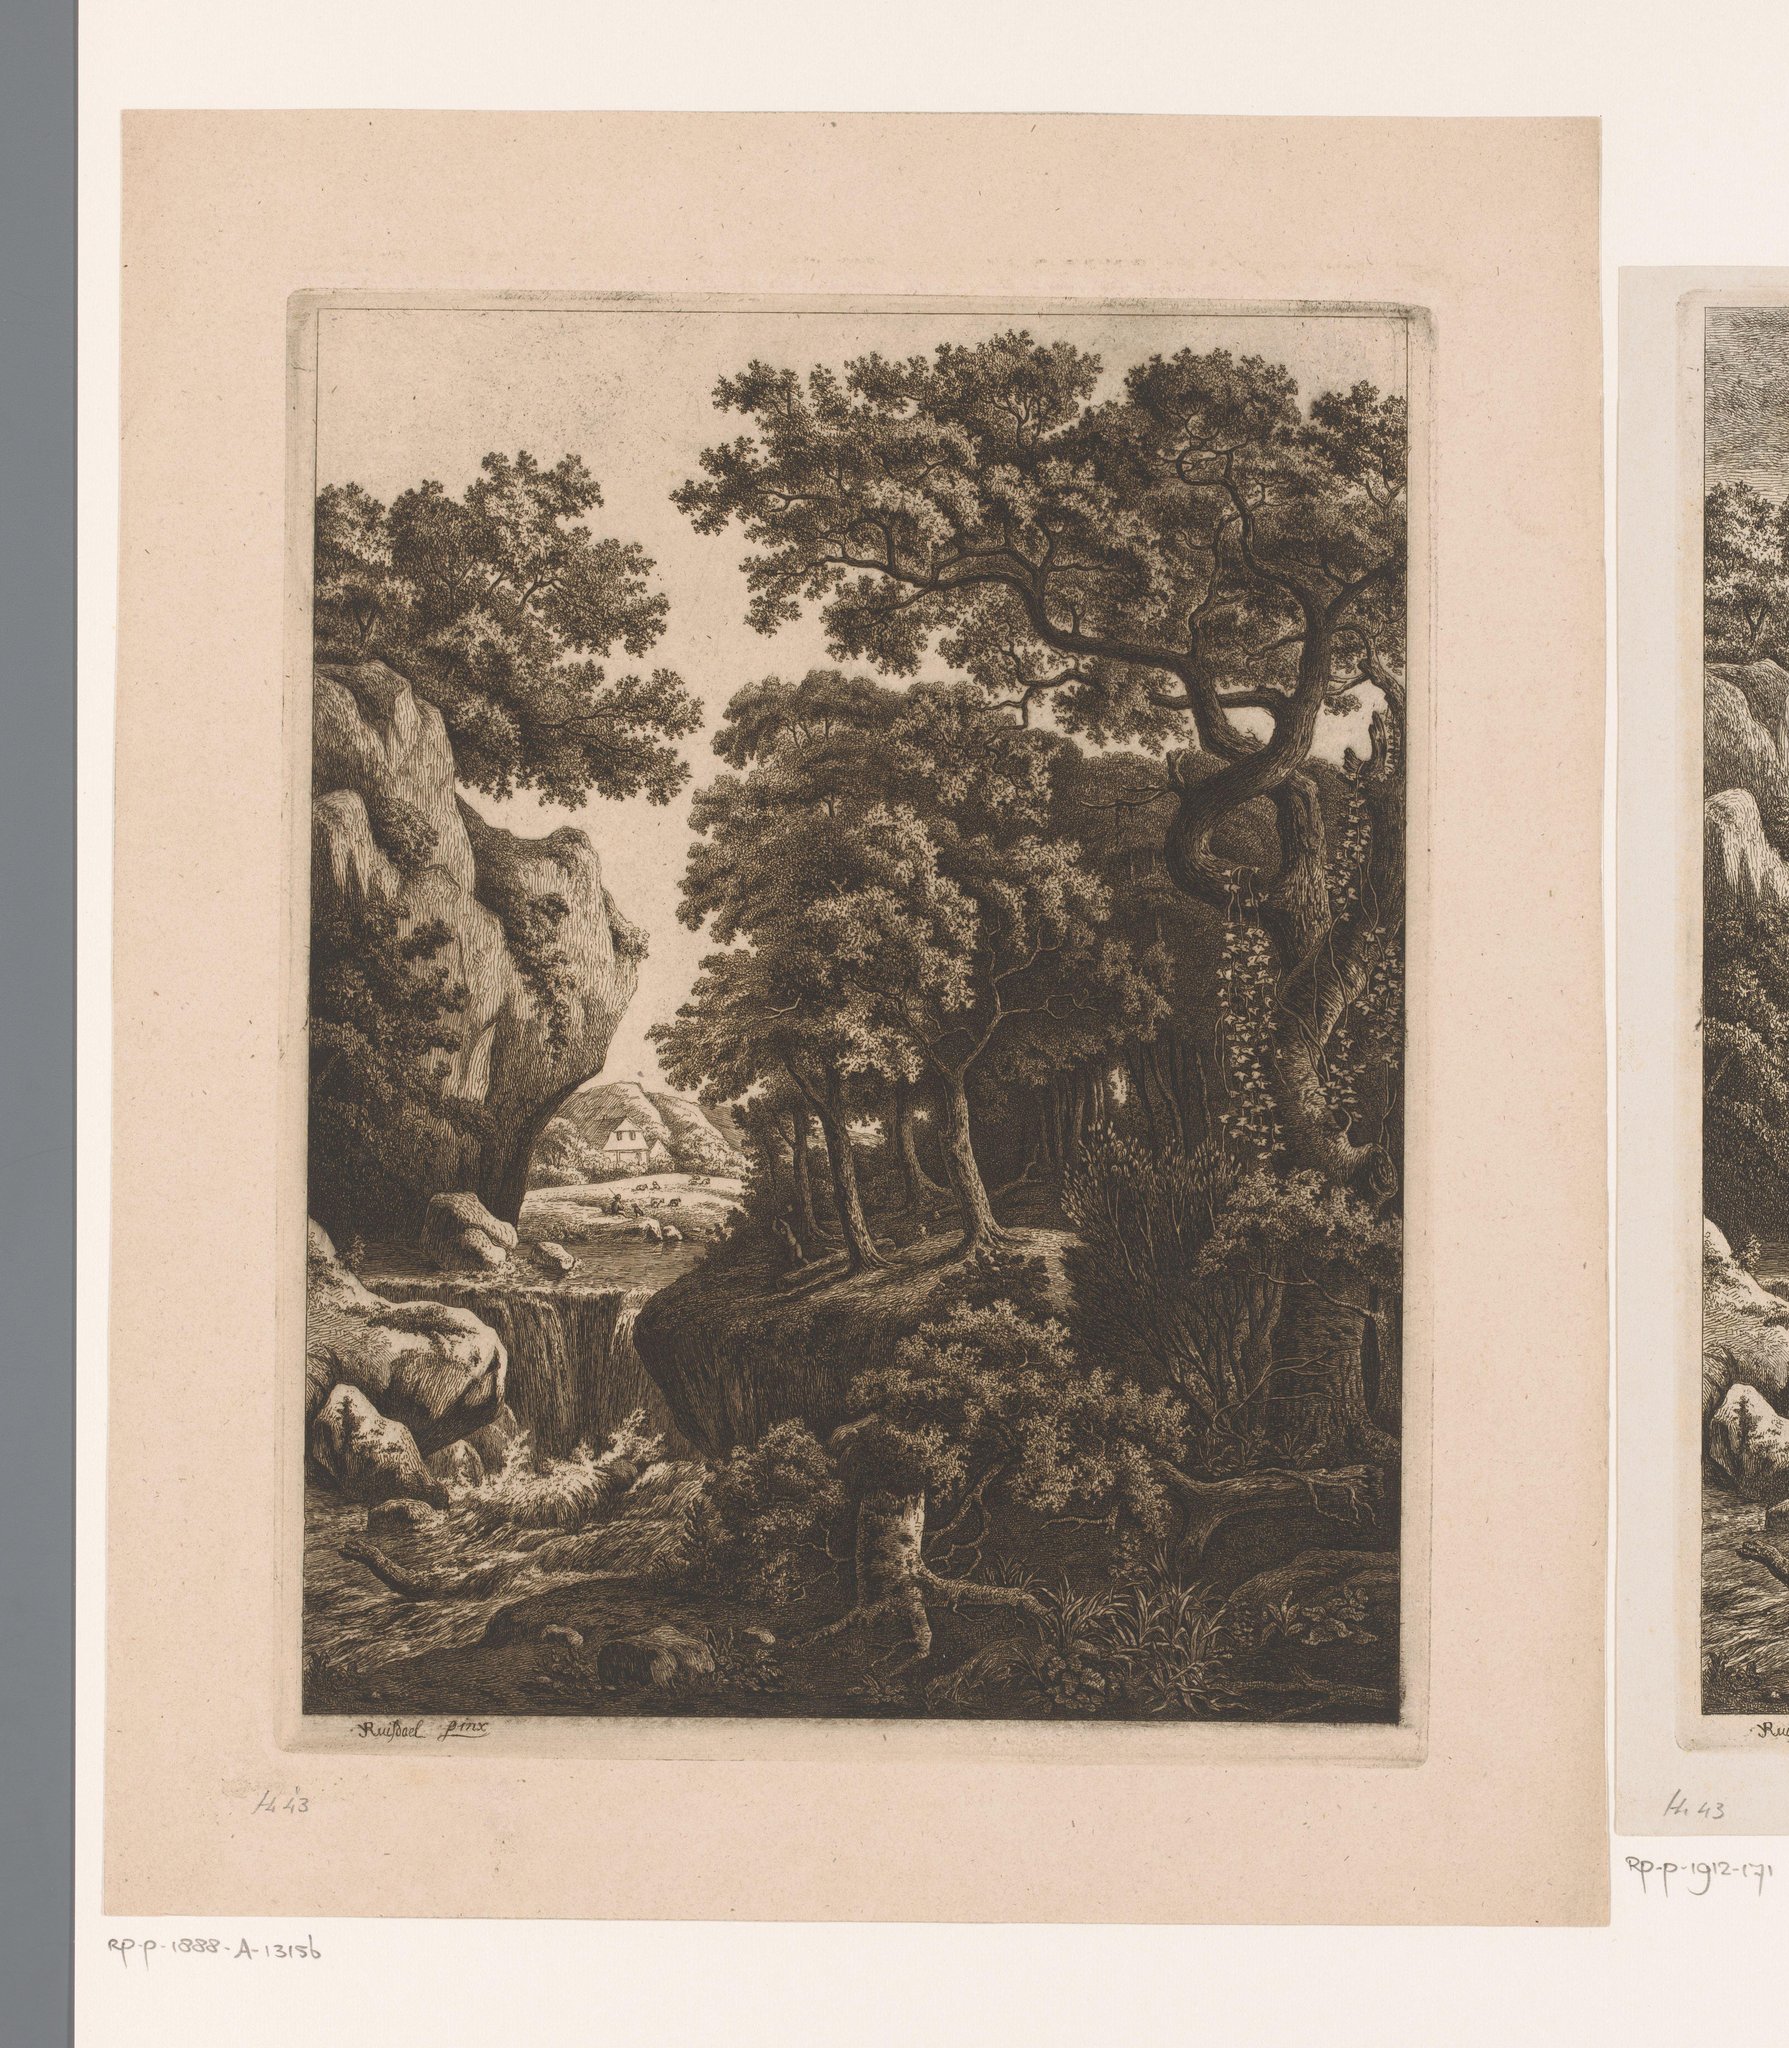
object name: print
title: Landschap met waterval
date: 1860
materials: paper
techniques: drypoint, etching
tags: waterfall, forest, wood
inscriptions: collector's mark: Lugt 2228